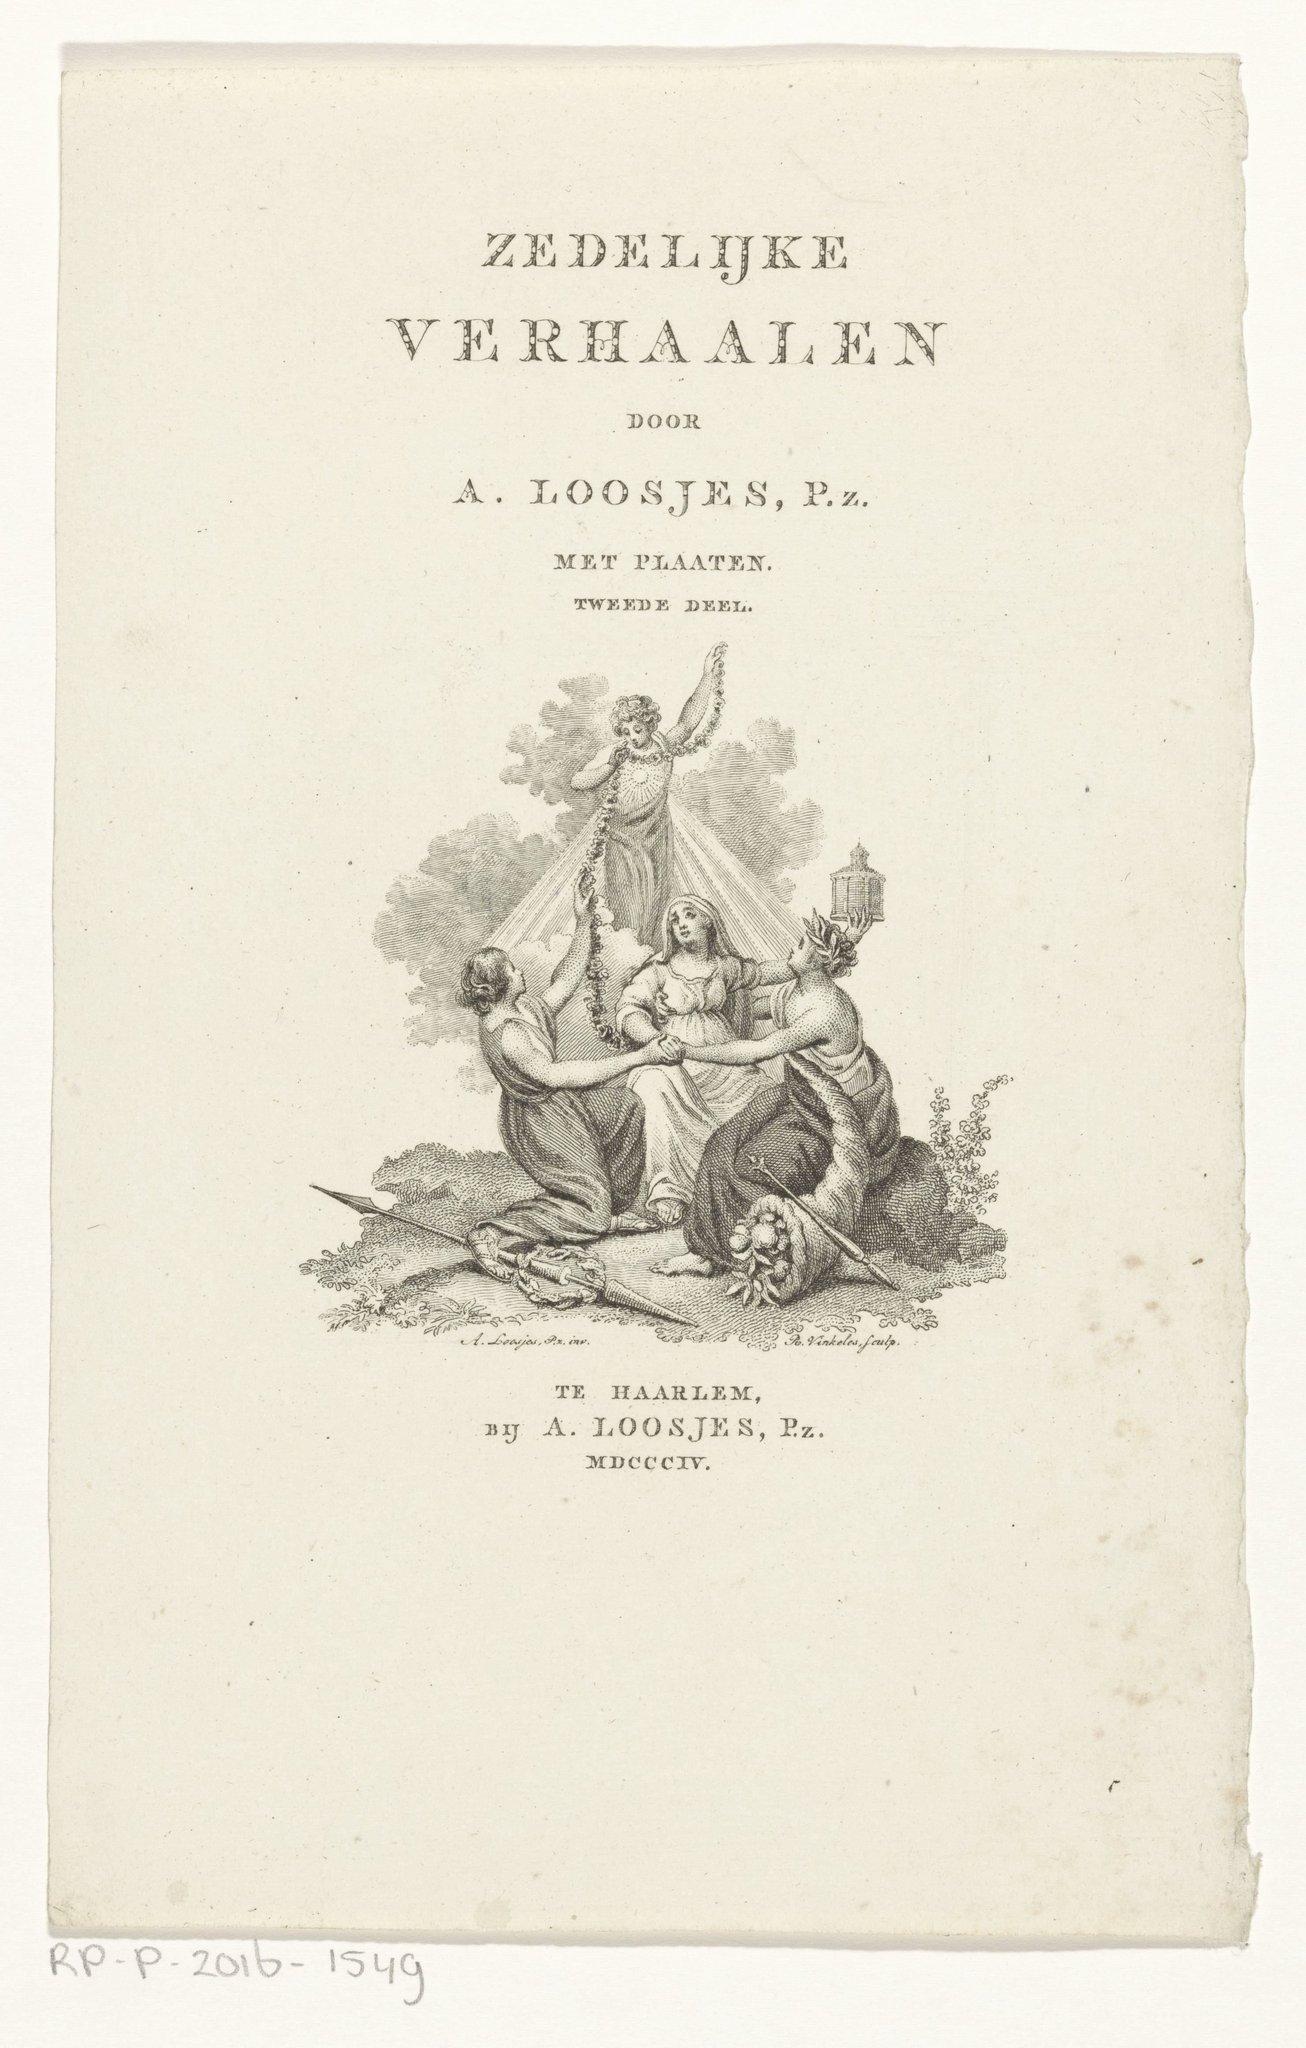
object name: titelblad, titelpagina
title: Titelpagina voor: Adriaan Pietersz. Loosjes, Zedelijke Verhaalen, 1804-1805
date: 1804-1805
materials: paper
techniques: engraving, etching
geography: haarlem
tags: 'cornucopia', horn of plenty, faith, 'fides'; 'fede', 'fede catholica', 'fede christiana', 'fede christiana catholica' (ripa) ~ one of the three theological virtues, the seven virtues (symbolized), truth; 'verità' (ripa), sun as celestial body, happiness, felicity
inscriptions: collector's mark: Lugt 2228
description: De personificaties van Godsdienst, Deugd en Geluk omhelzen elkaar. Zij worden verlicht door de Waarheid boven hen. Waarheid verbindt met een guirlande als symbool voor Vreugde het drietal.